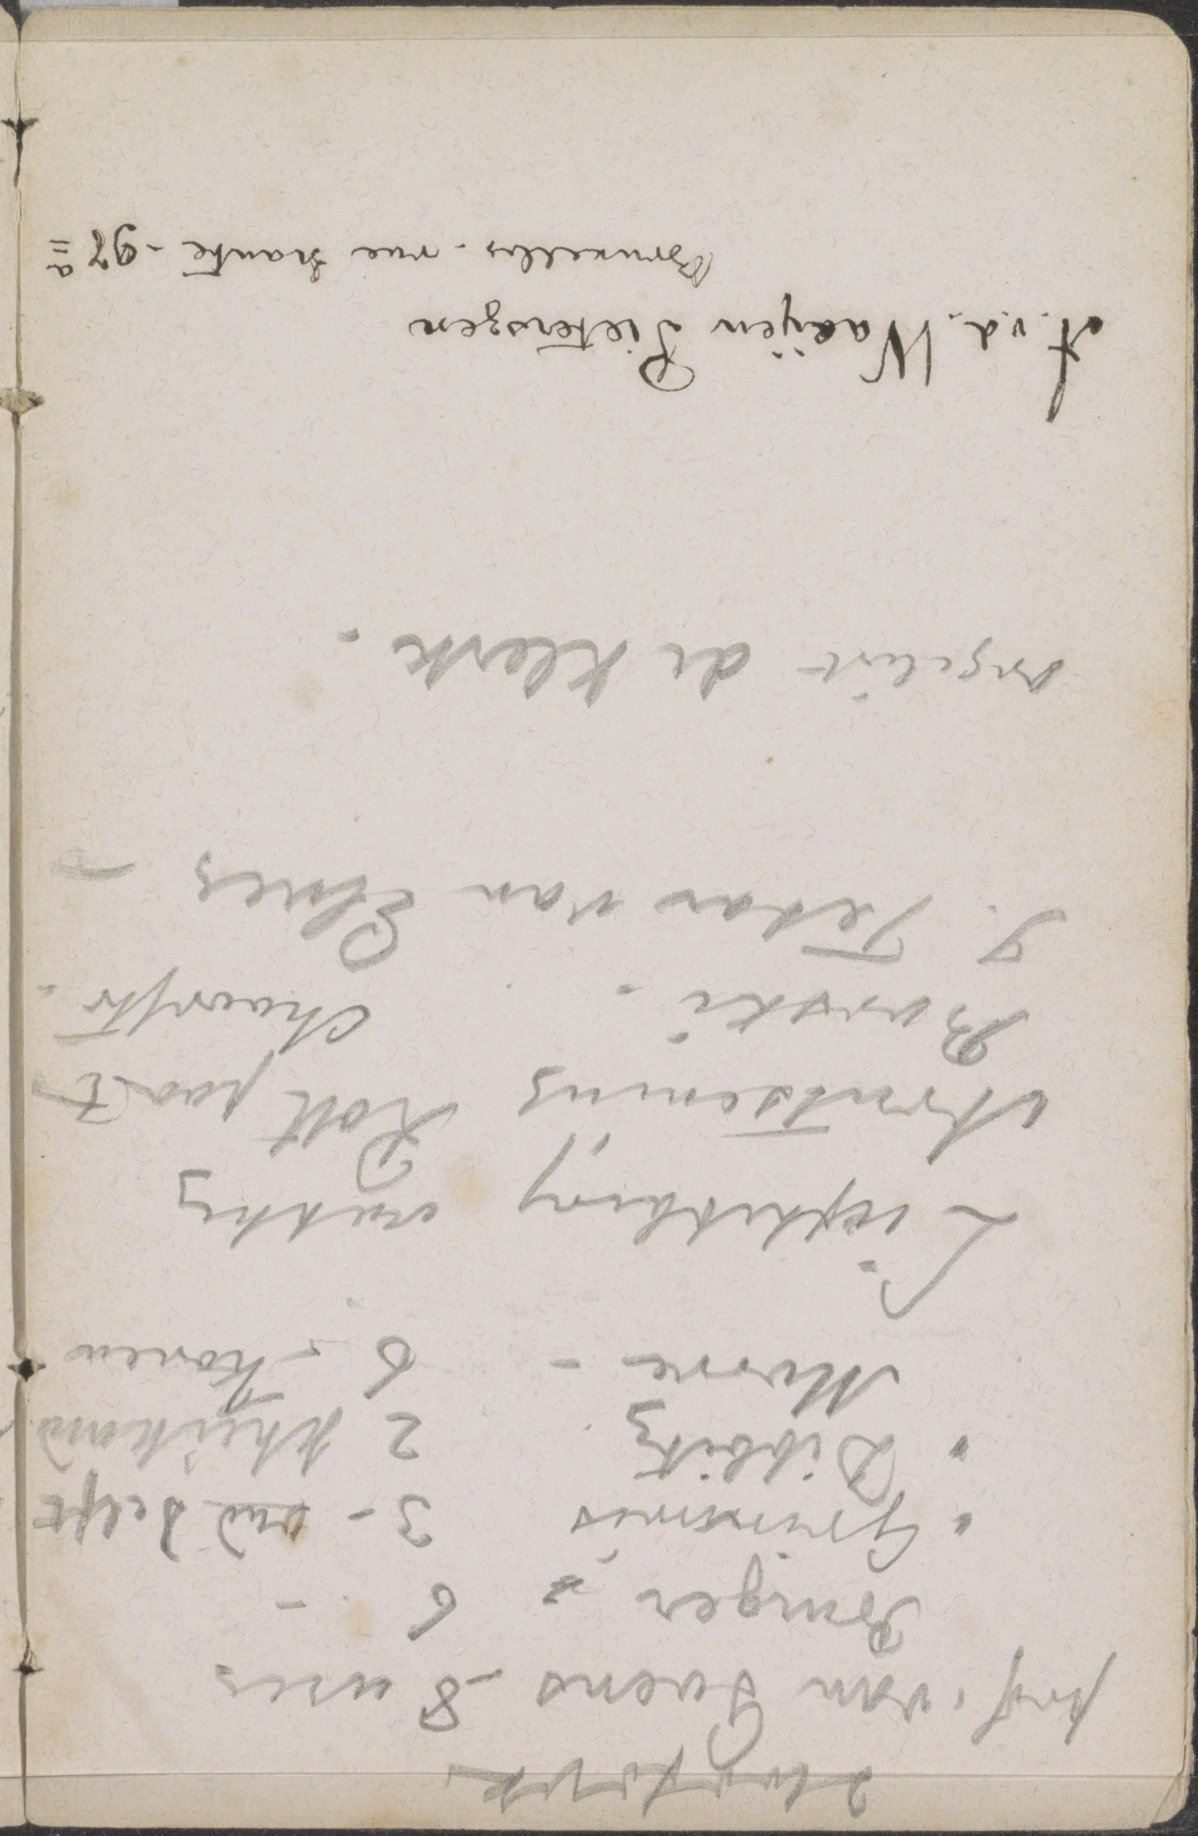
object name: sketchbook leaf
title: Notities, waaronder adressen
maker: johannes tavenraat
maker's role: draughtsman, painter, print maker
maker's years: 1809-1881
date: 1862-1864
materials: ink, paper, pencil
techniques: pen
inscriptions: annotation: ‘[...]’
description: Blad 61 recto uit een schetsboek met 65 bladen.